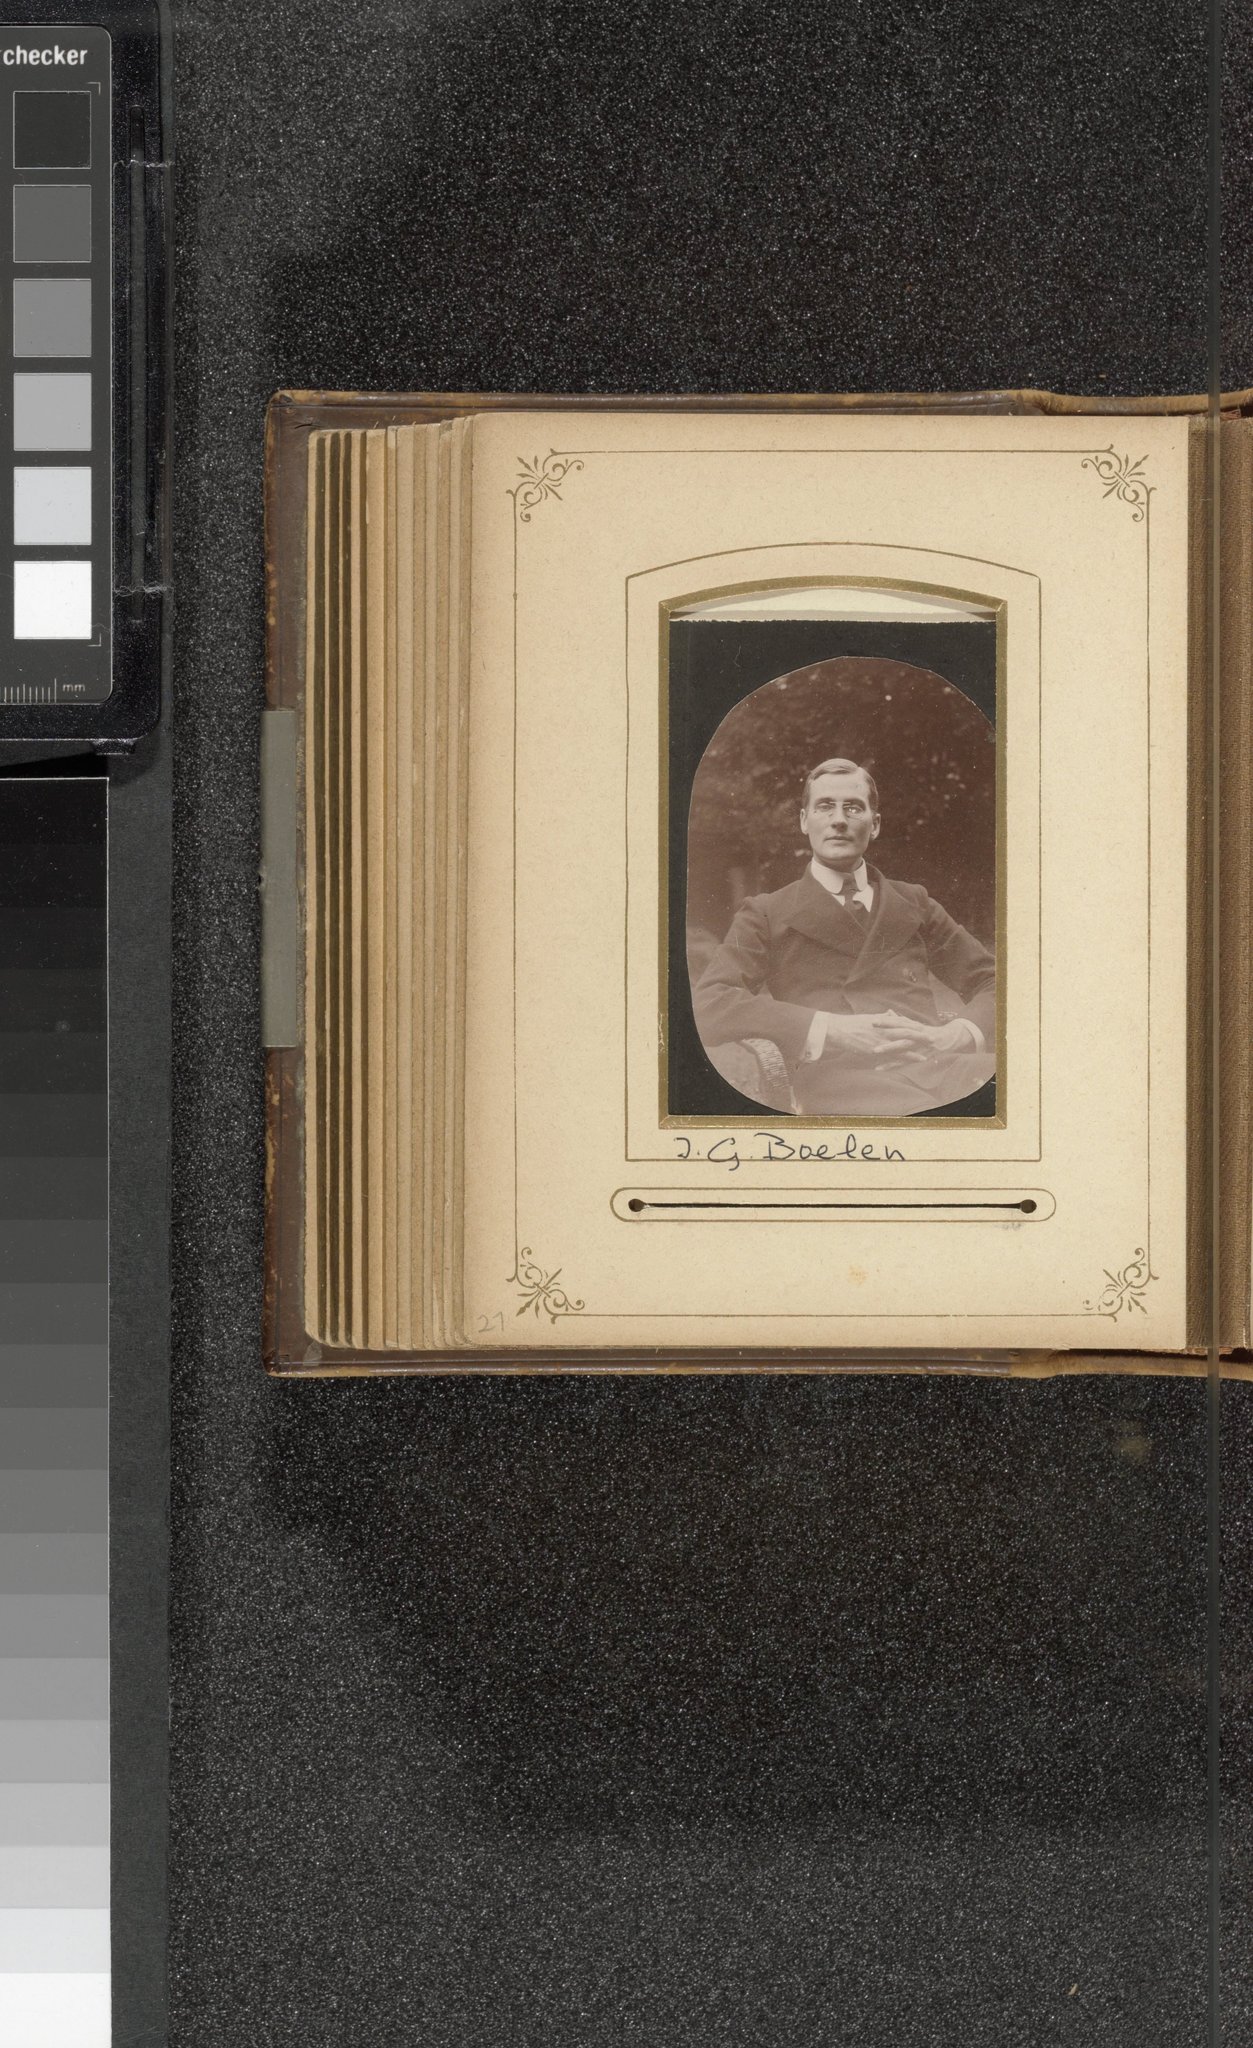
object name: photograph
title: Portret van J.G. Boelen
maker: Anonymous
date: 1910-1920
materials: cardboard, paper, photographic support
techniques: collodion silver print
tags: amsterdam, joan gerard boelen, studio requisites ~ photographer, historical persons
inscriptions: name: ‘J.G. Boelen’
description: Onderdeel van Fotoalbum van de families Boelen, Matthes en Pennink.